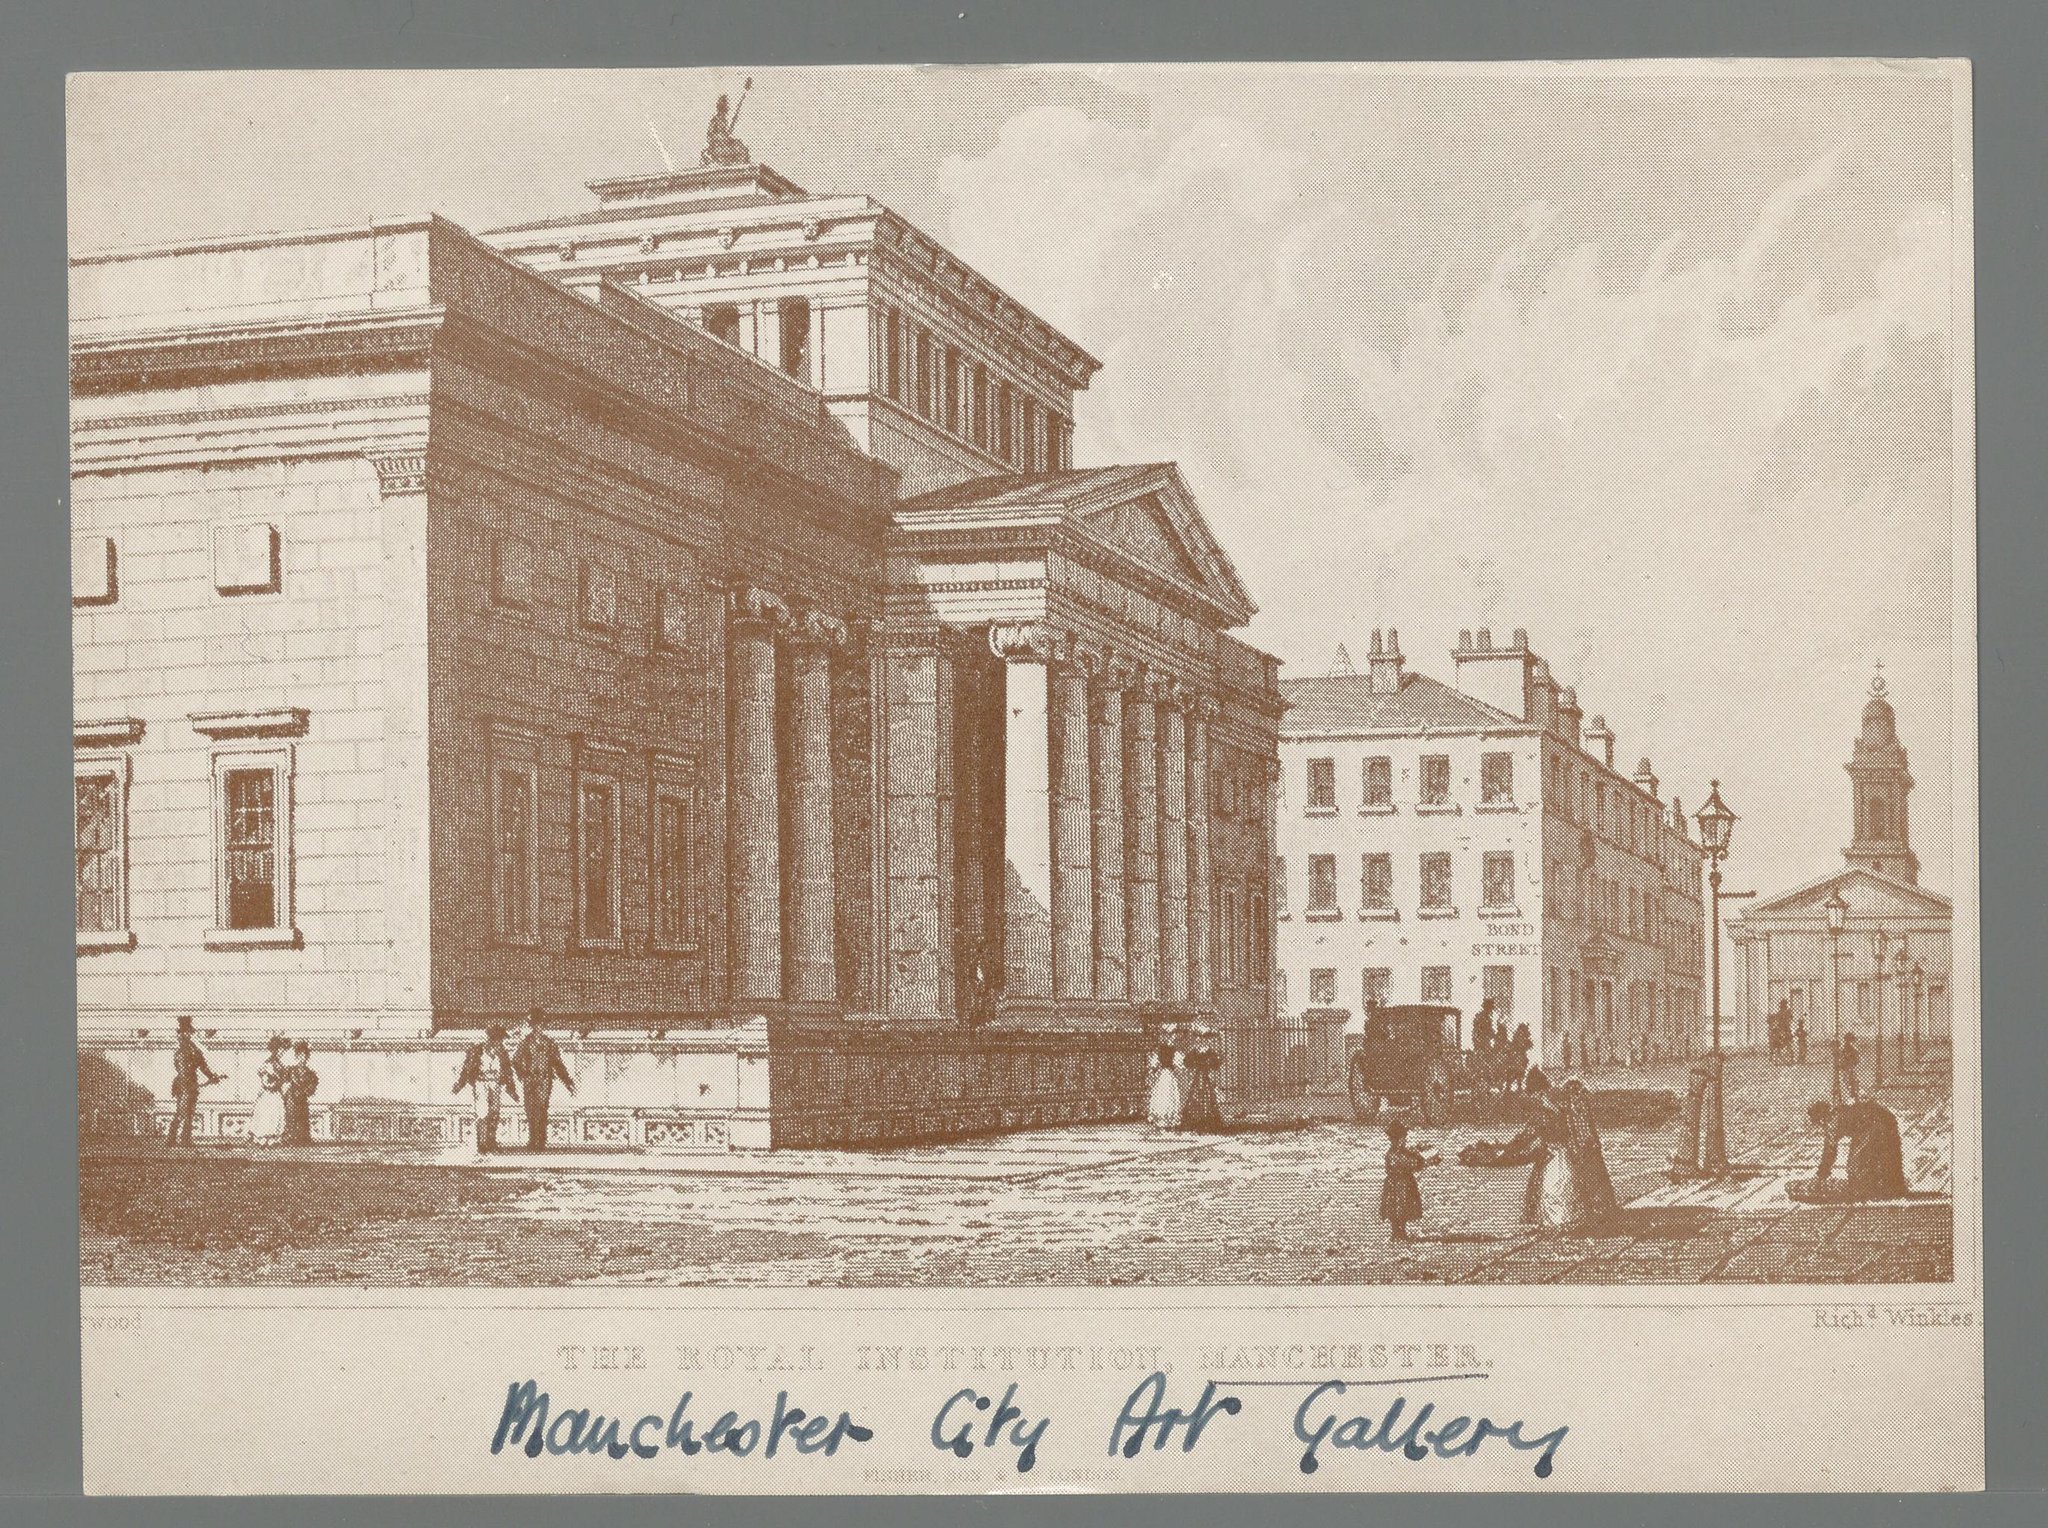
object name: reproduction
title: The Royal Institution, Manchester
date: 1973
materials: cardboard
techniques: printing, writing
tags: city-view, and landscape with man-made constructions, permanent exhibition, museum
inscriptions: date